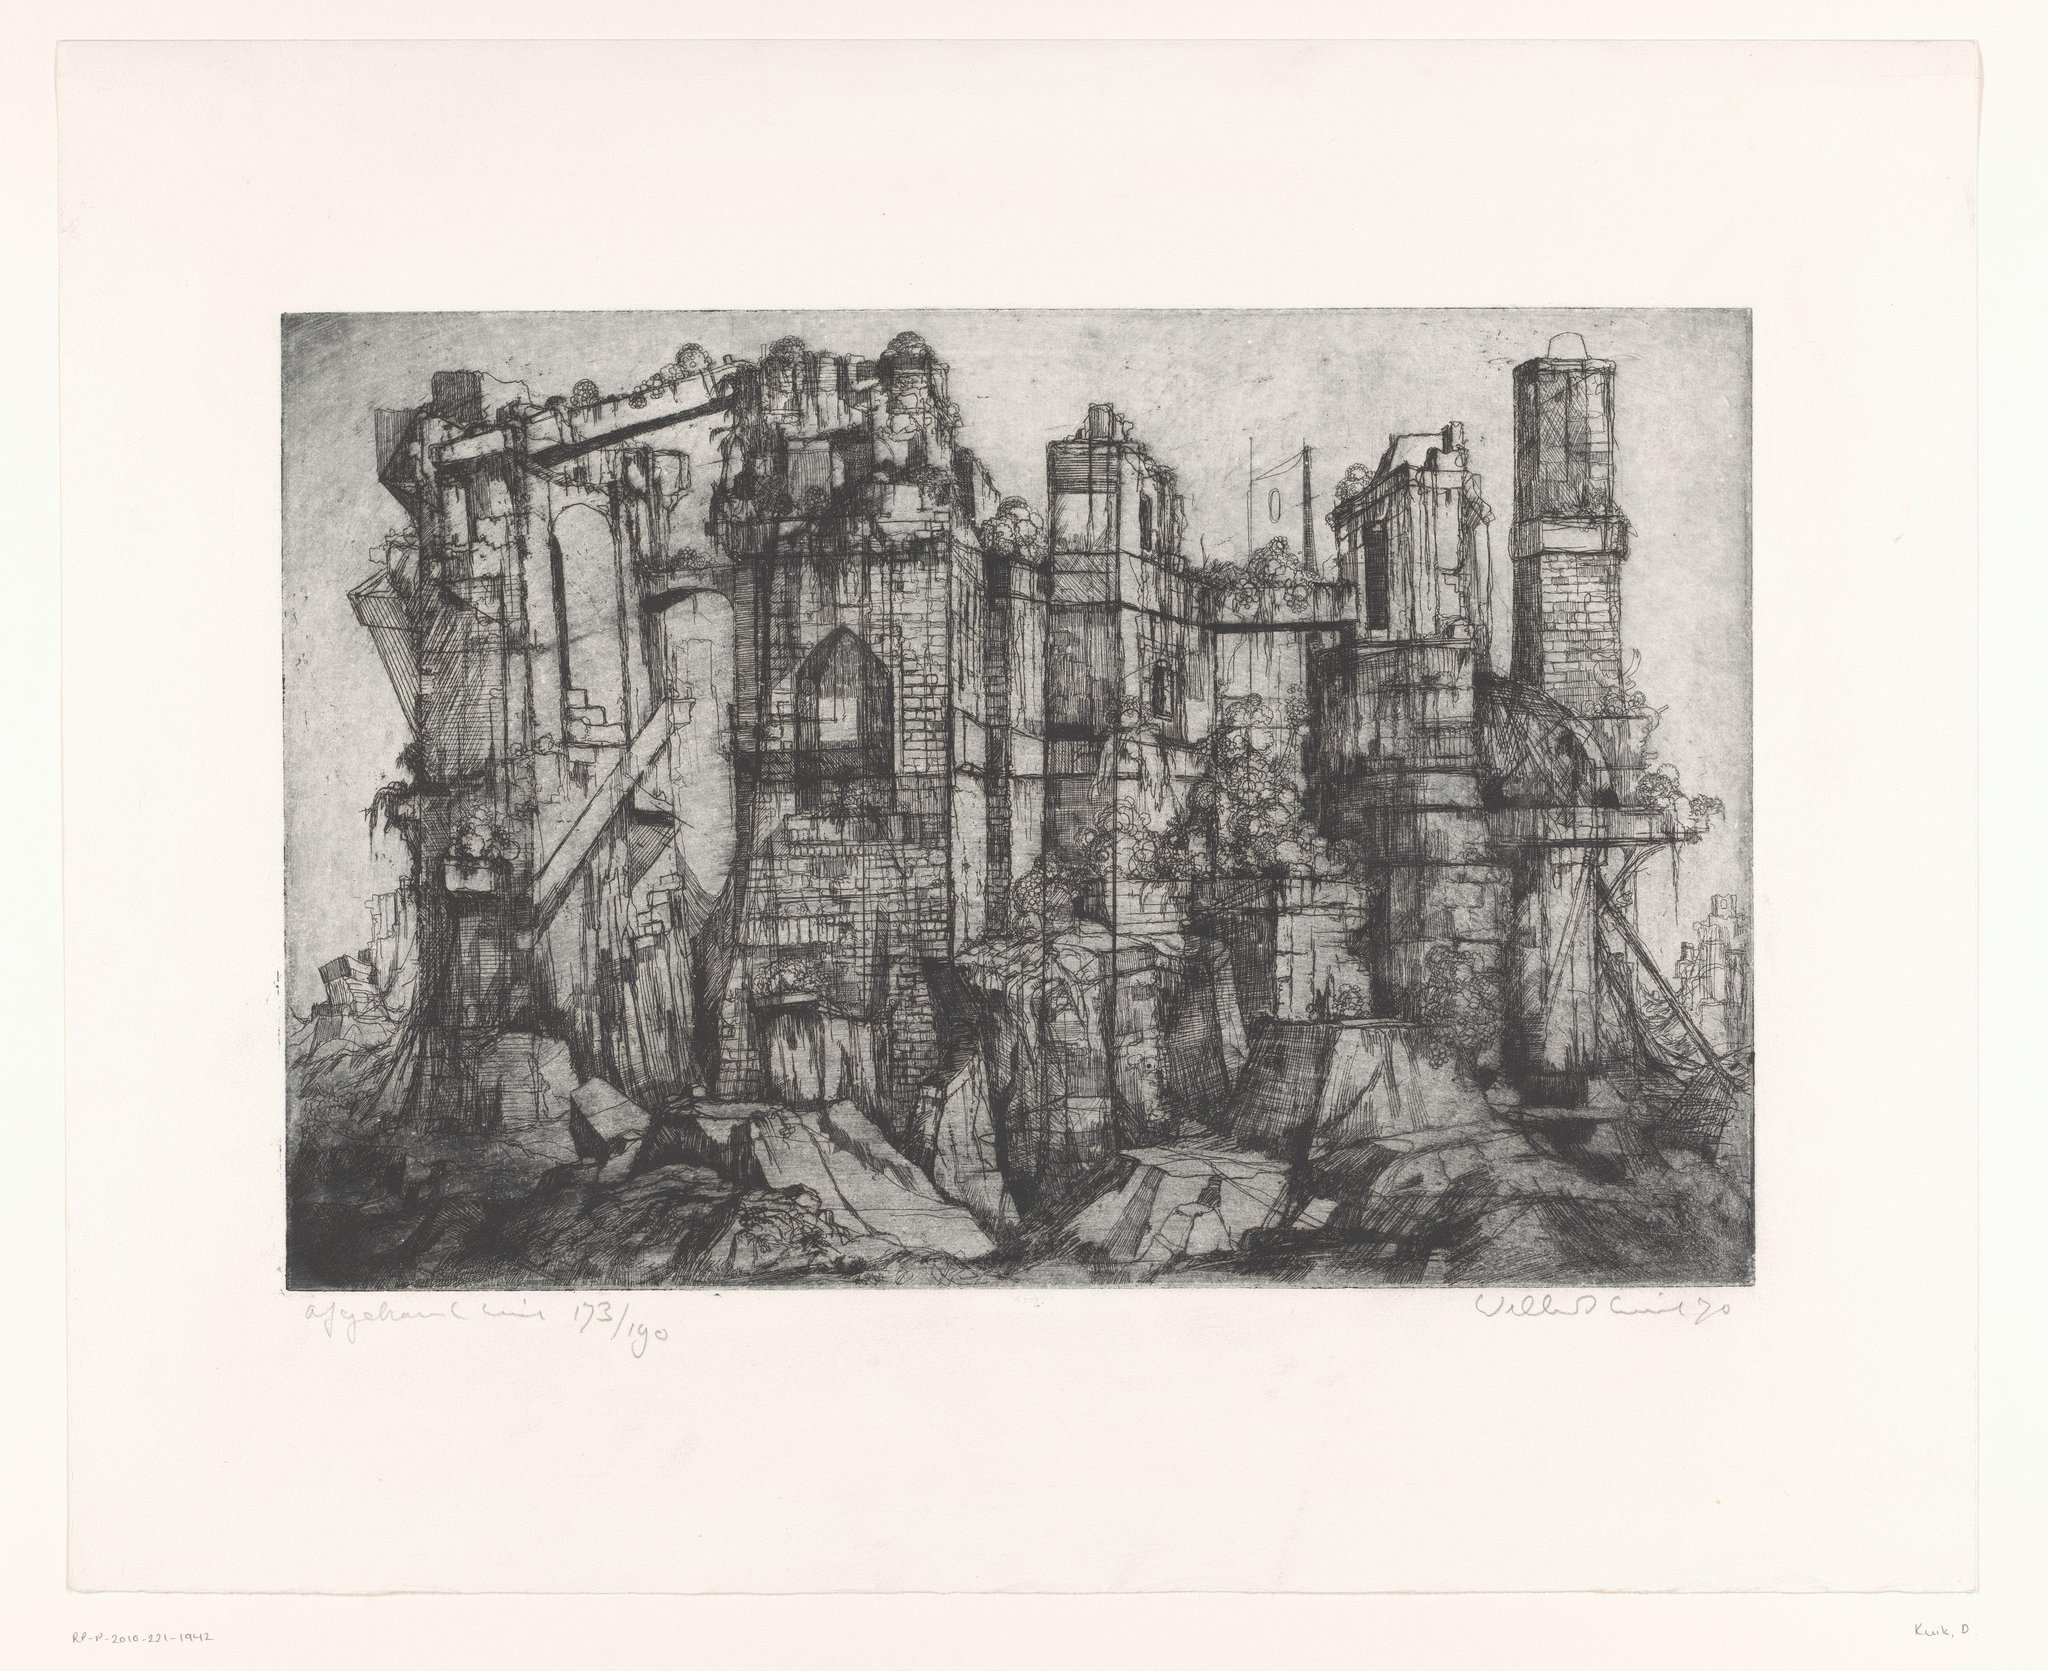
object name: print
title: Afgebrand huis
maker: dirkje kuik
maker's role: print maker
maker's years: 1929-2008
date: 1970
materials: paper, ink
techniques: aquatint, etching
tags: ruin of a building ~ architecture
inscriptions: signature and date: ‘WillemD Kuik 70’, edition: ‘173/190’, title: ‘Afgebrand huis’